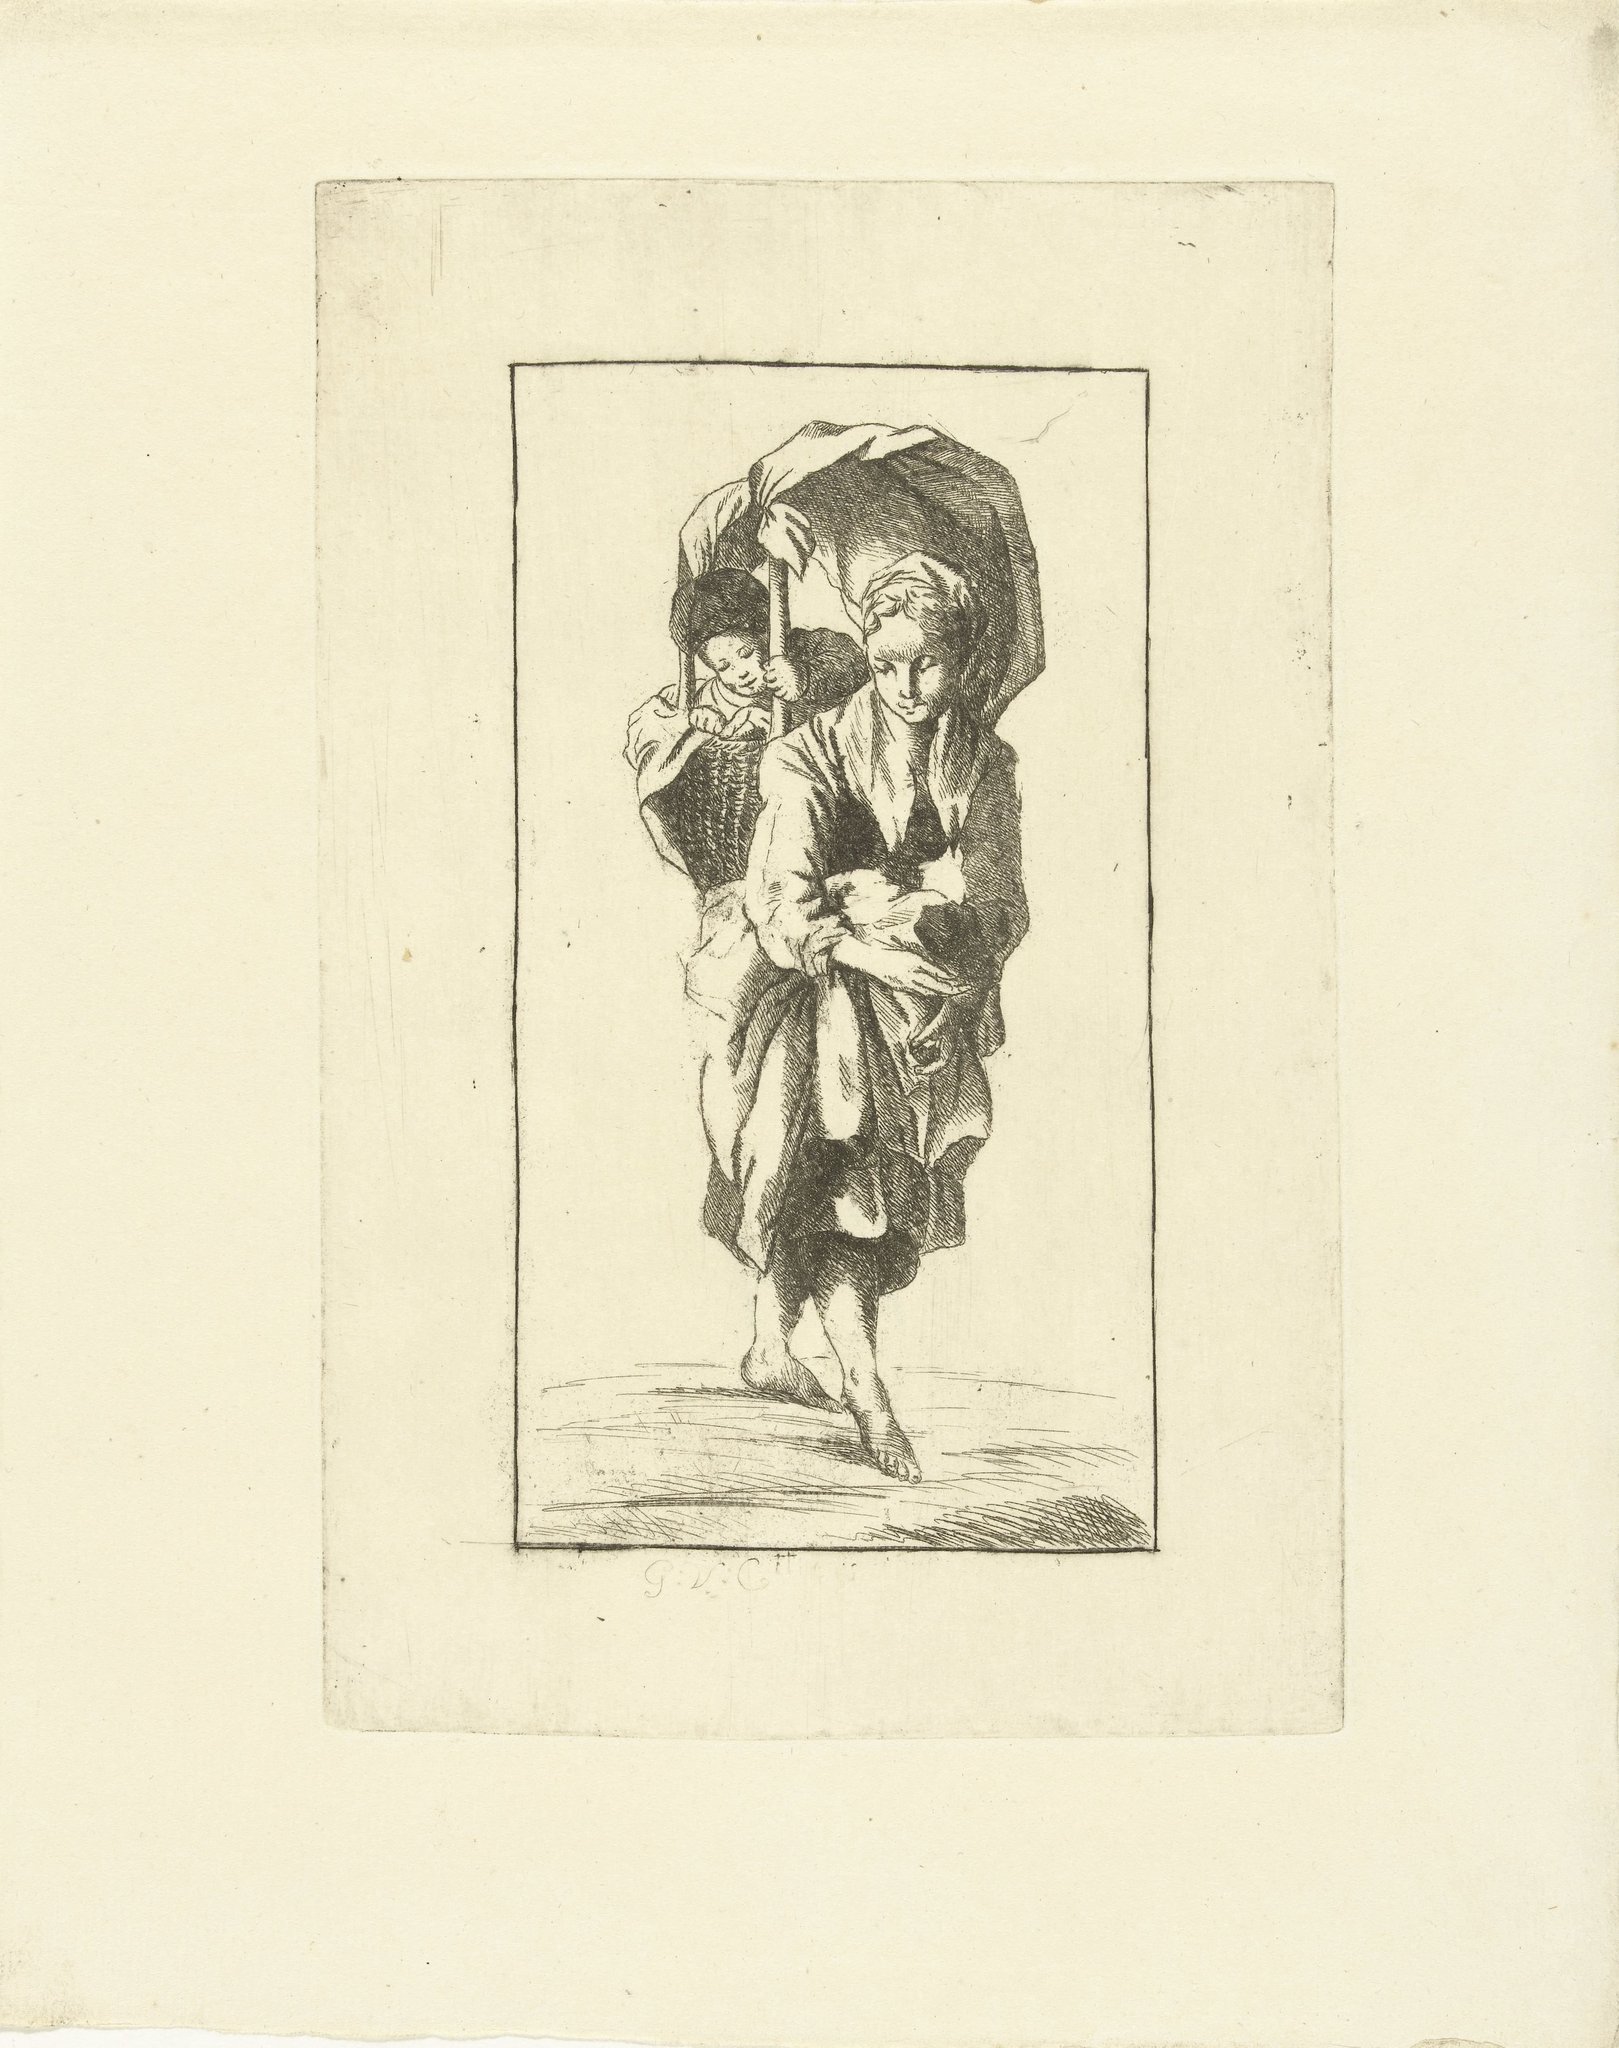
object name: print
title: Jonge vrouw met kind in een mand op haar rug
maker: g. van citters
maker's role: print maker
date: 1750-1800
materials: paper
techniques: etching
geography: netherlands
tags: carrying a child on the back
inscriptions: collector's mark: Lugt 2233